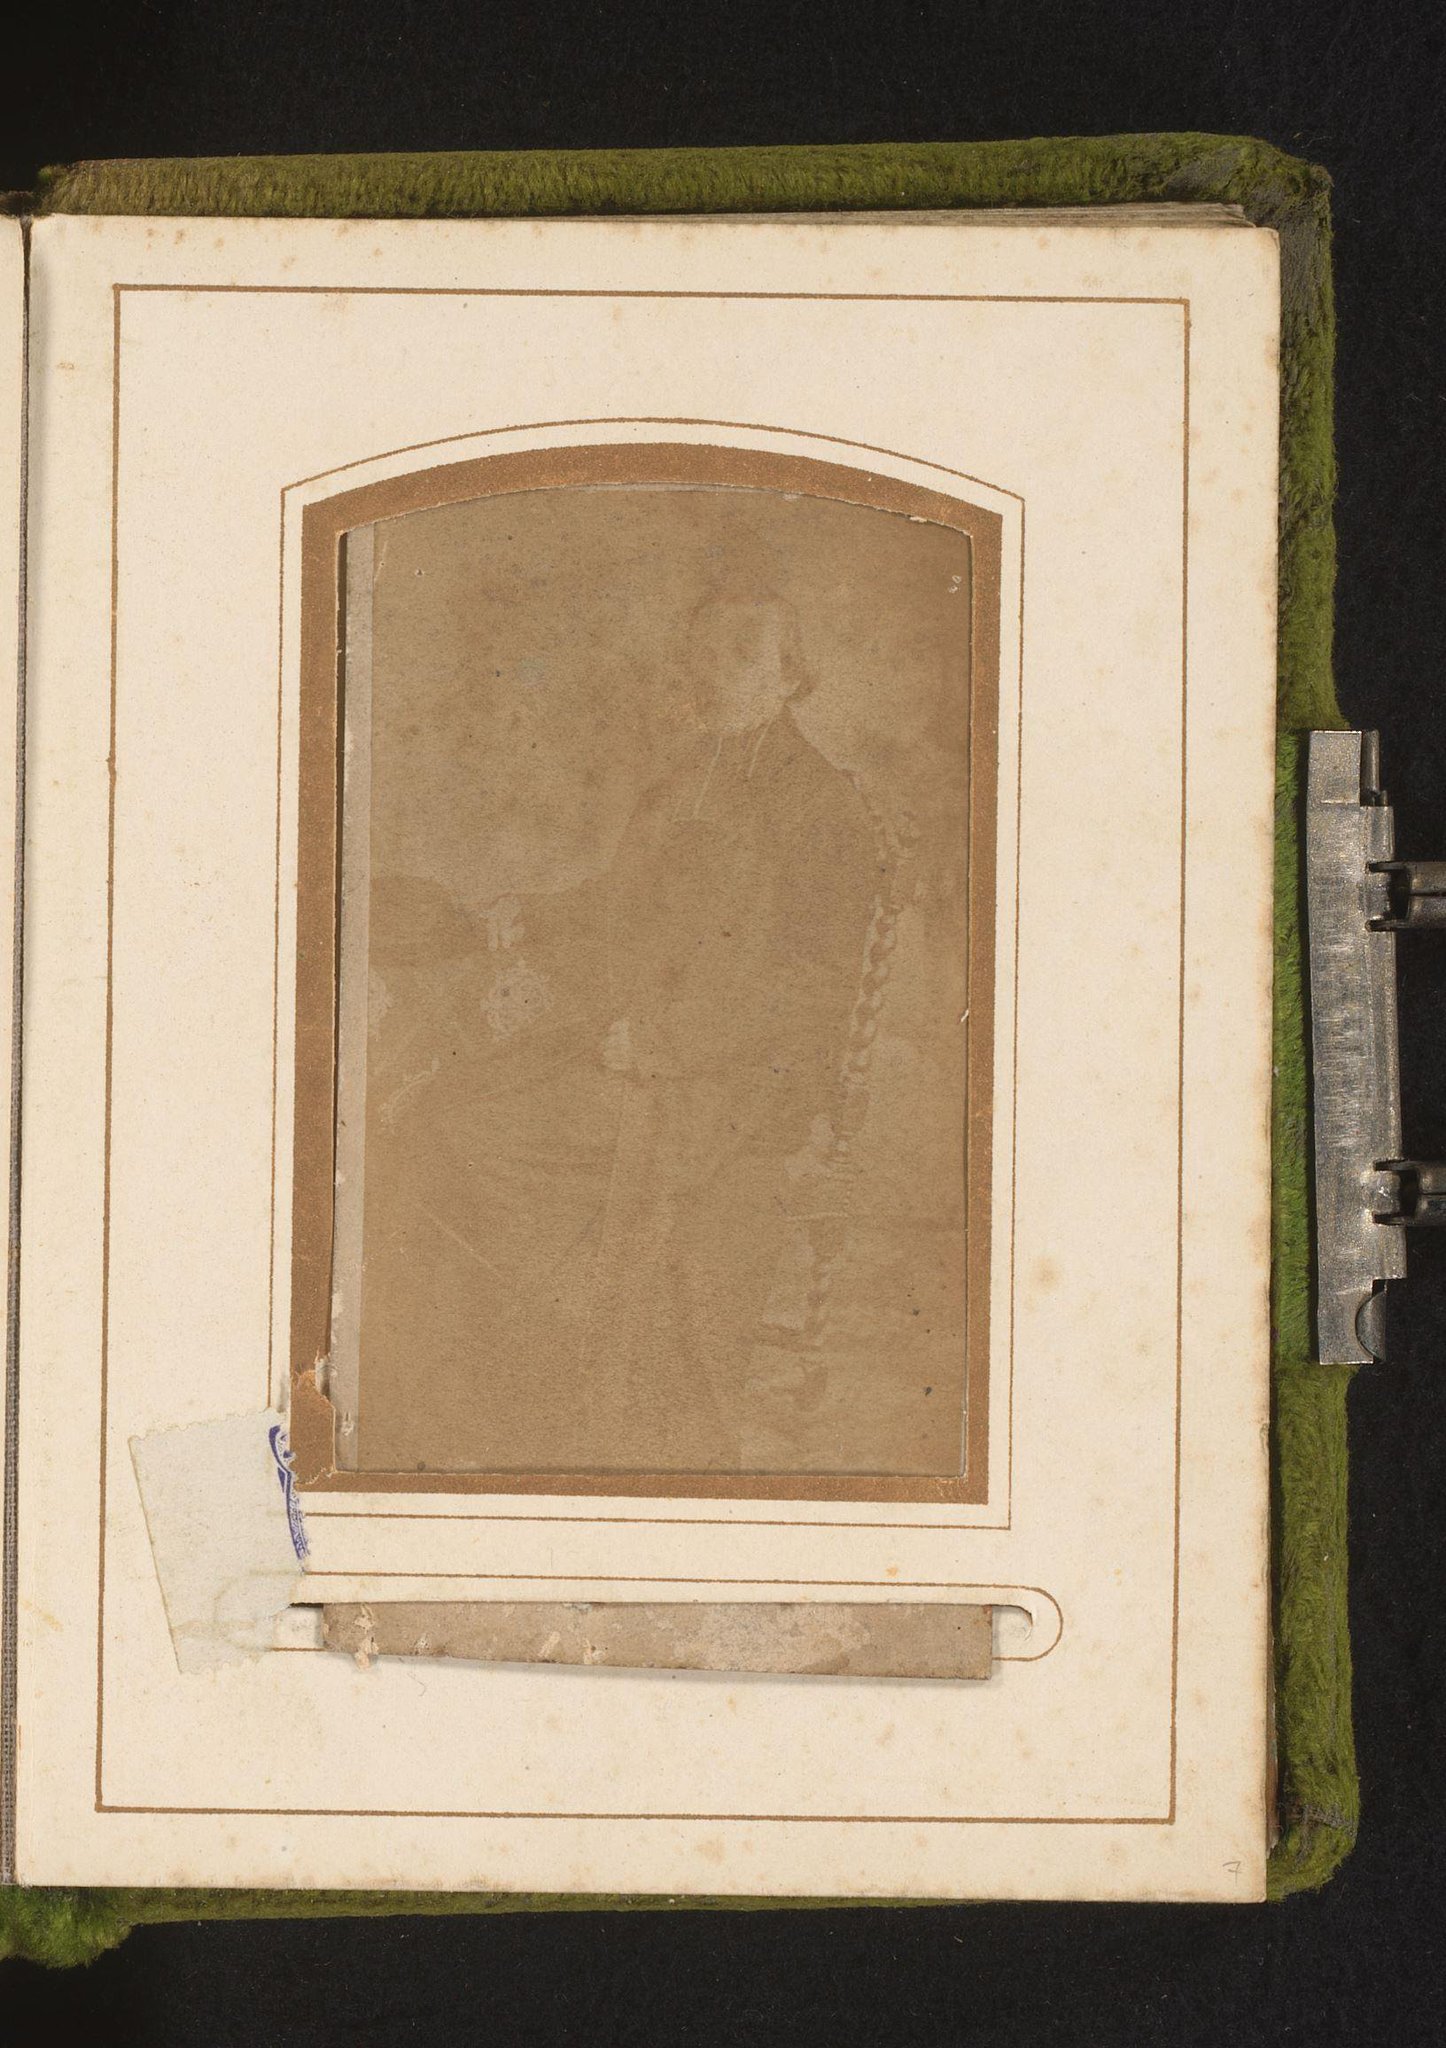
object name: album leaf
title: Portret van een man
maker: Anonymous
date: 1860-1900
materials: cardboard, photographic support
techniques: albumen print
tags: adult man, historical persons, organization, functionaries and dignitaries in churches and in related institutions